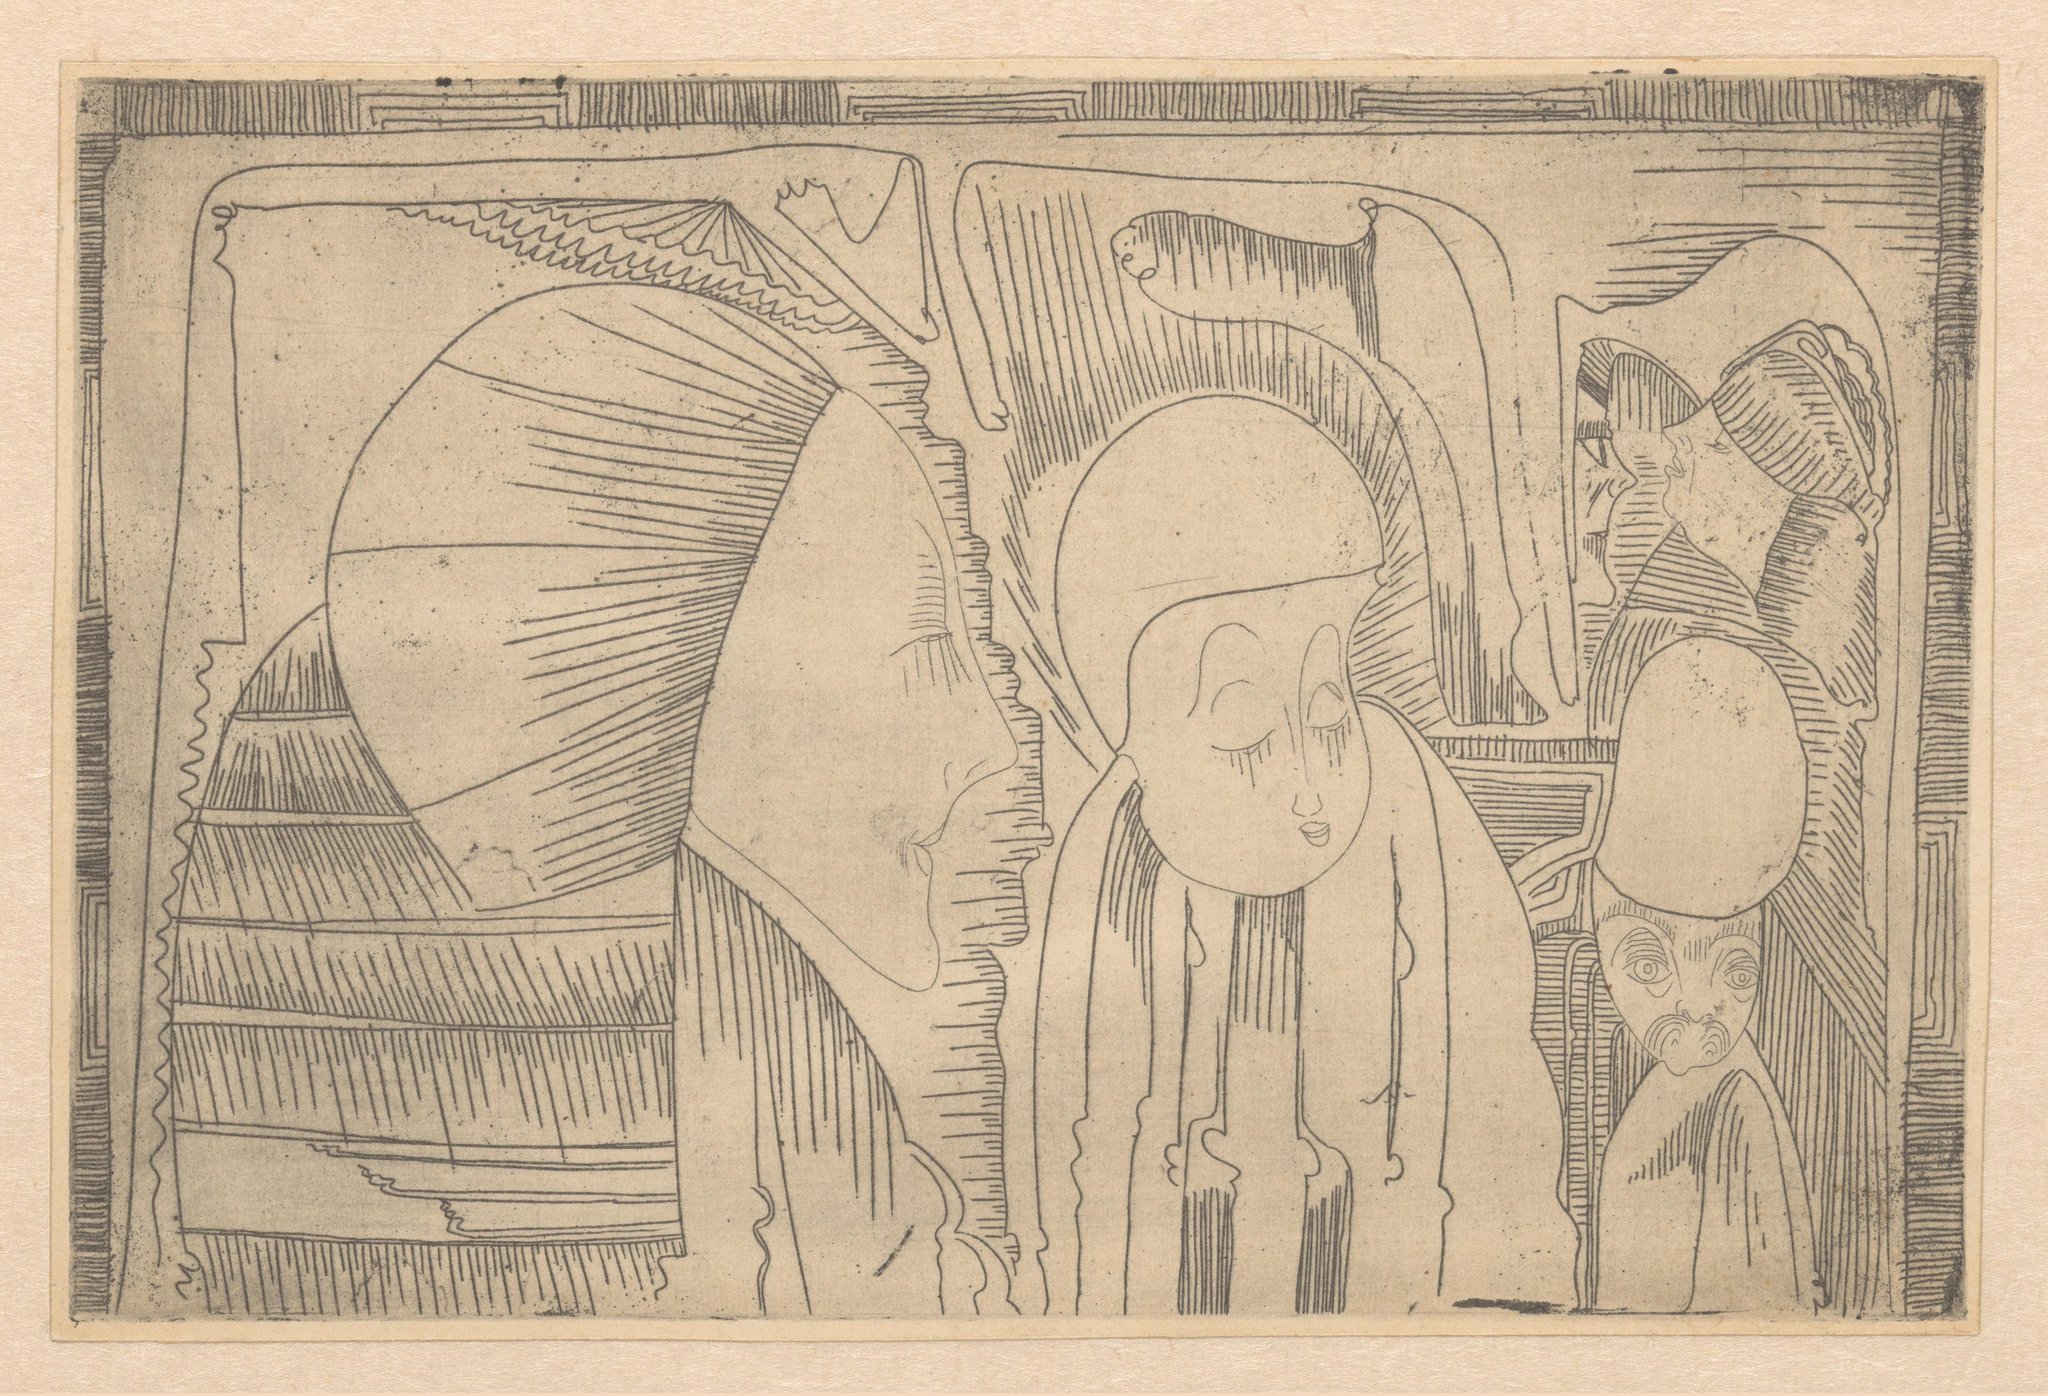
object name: print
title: Vijf koppen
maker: samuel jessurun de mesquita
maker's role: draughtsman, print maker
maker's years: 1868-1944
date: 1924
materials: paper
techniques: etching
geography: netherlands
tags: caricatures (human types), eyes closed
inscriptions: collector's mark: Lugt 2228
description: Vijf koppen: op de voorgrond een kop in profiel, naar rechts, met neergeslagen ogen; in het midden een figuur van voren gezien, eveneens met de ogen dicht. Rechts een kop van een man met wijd open ogen. Op de achtergrond twee koppen tegenover elkaar.